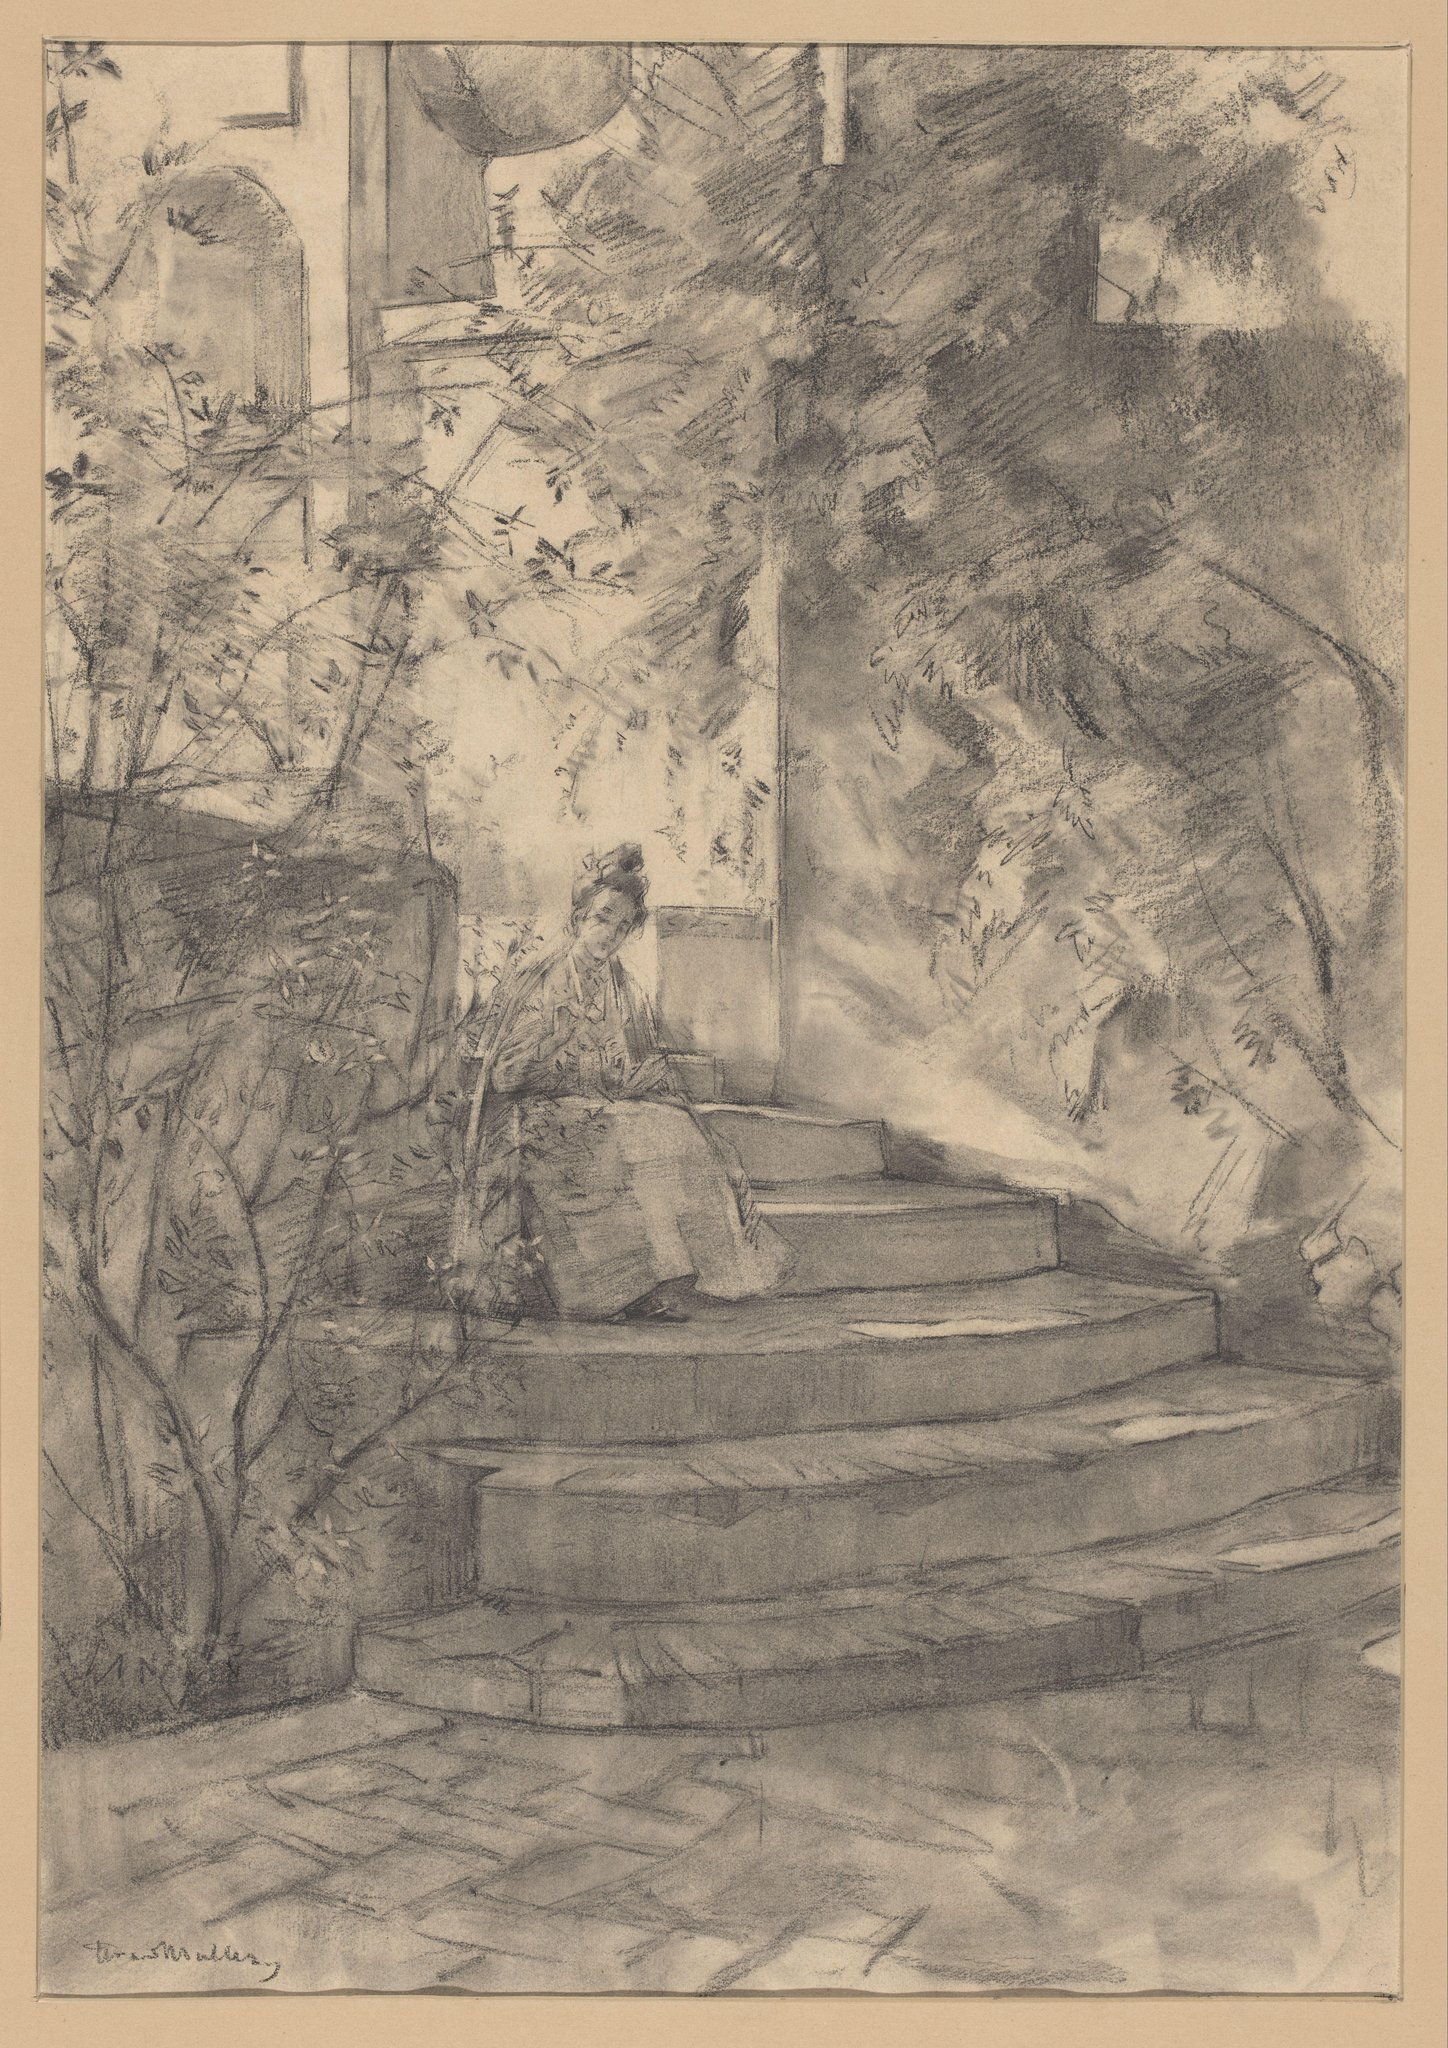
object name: drawing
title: Vrouw in de tuin van het Koninklijk Paleis te Sevilla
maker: gerard muller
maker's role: draughtsman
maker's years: 1861-1929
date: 1871-1903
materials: chalk, paper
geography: sevilla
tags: garden, palace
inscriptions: collector's mark: Lugt 2228, label: ‘15. Alcázar Sevilla/ In den tuin.’